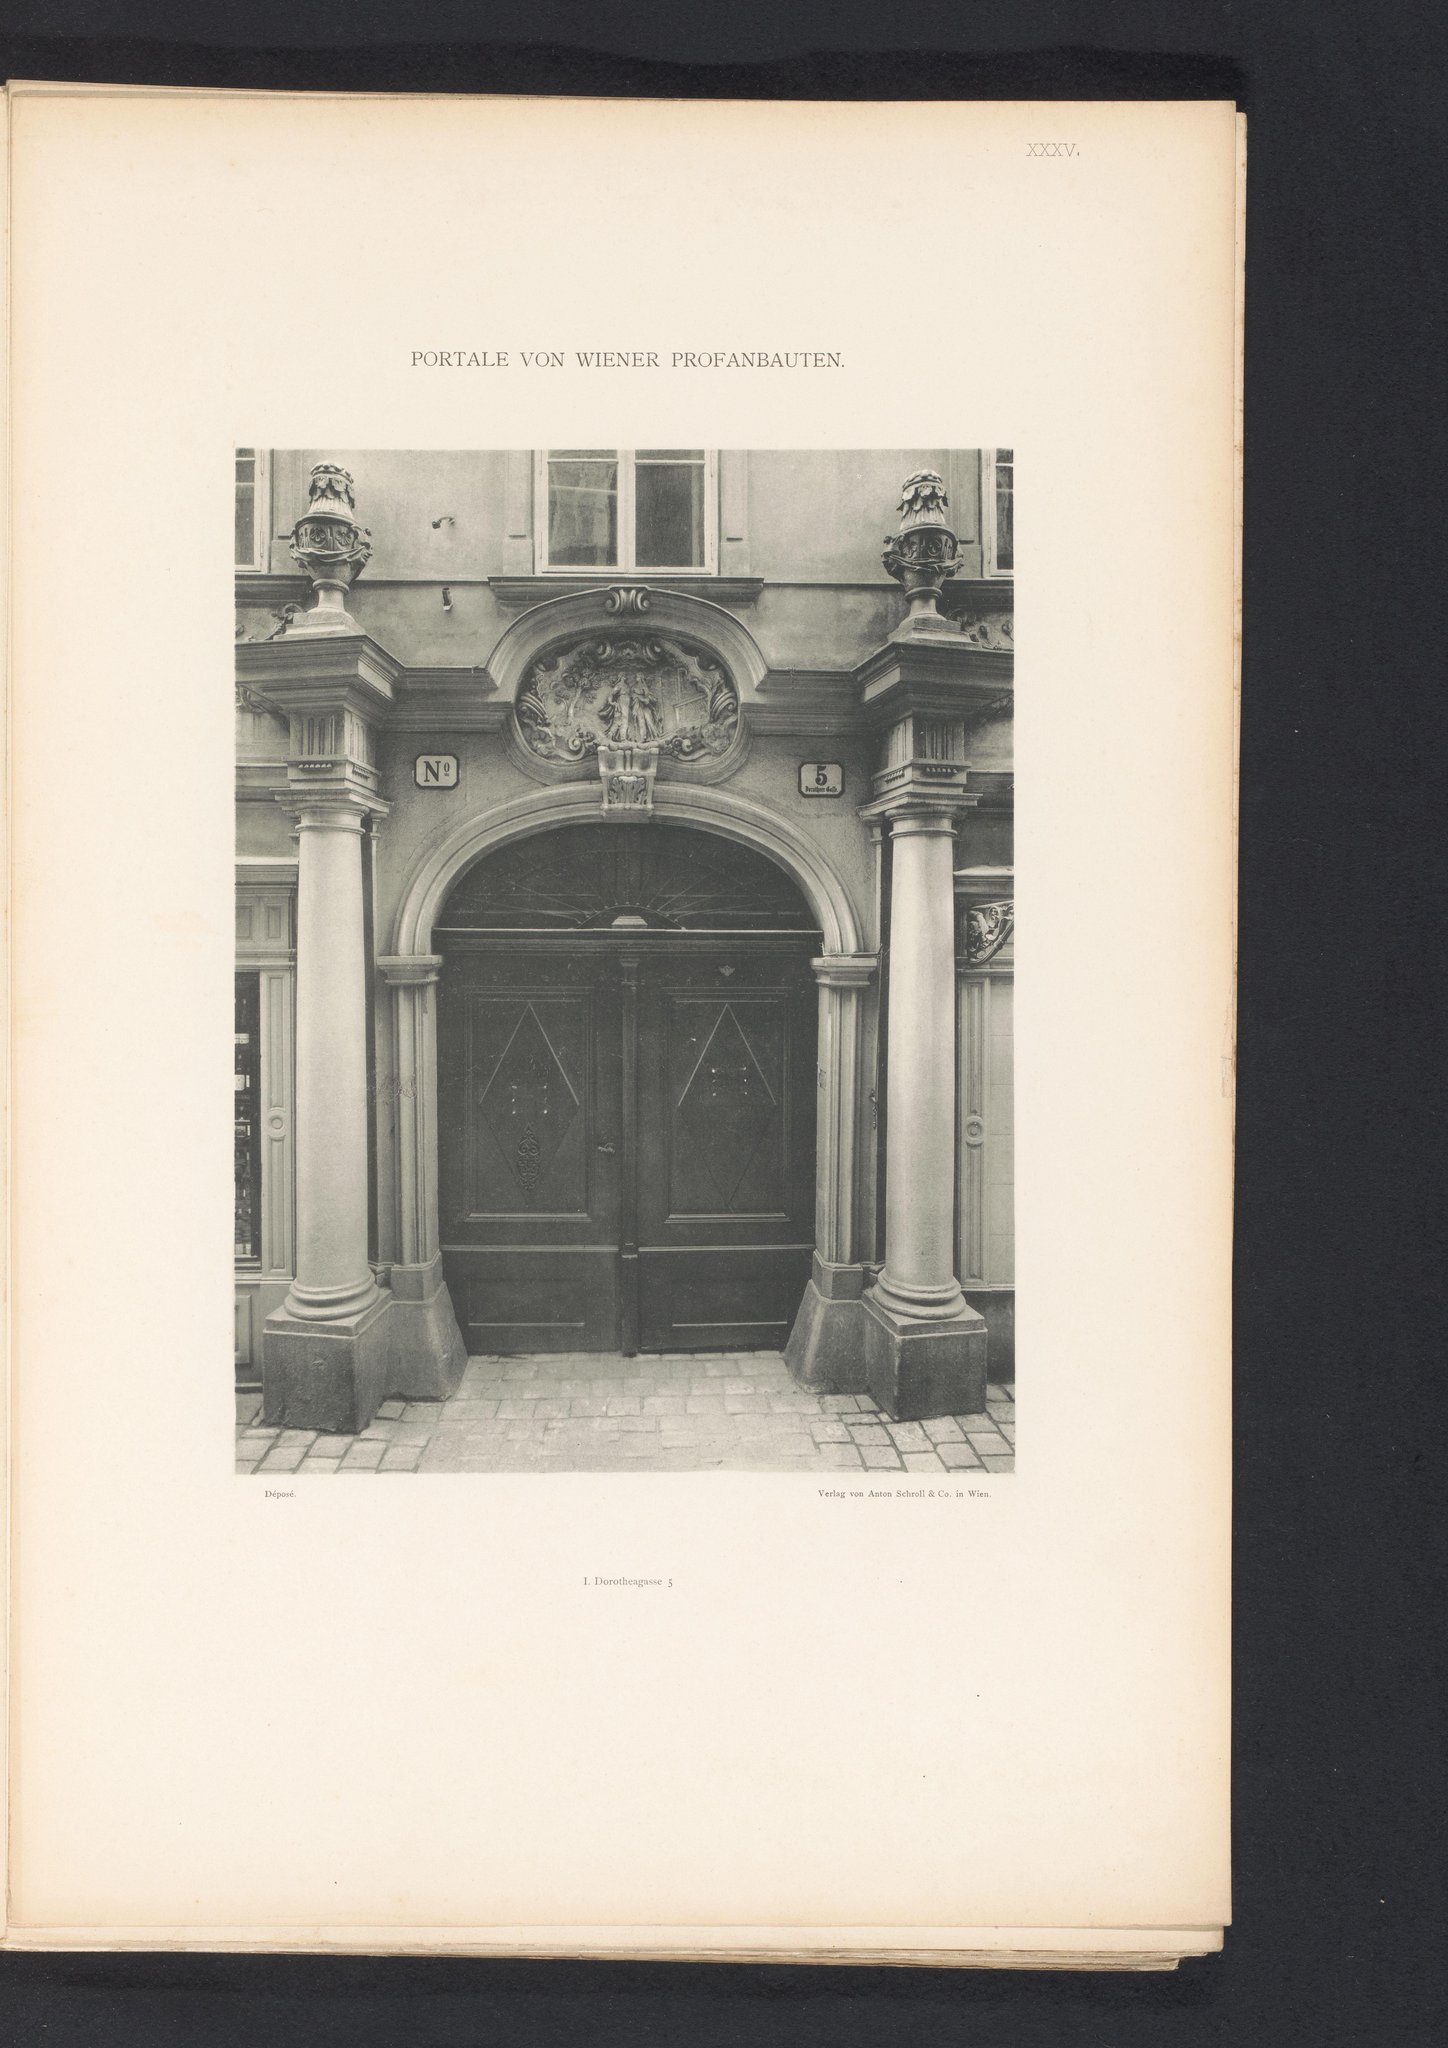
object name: page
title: Toegangsportaal van een pand aan Dorotheagasse 5 te Wenen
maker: Anonymous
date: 1884-1894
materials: paper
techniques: photograph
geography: austria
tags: gate, entrance, façade (of house or building)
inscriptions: inscription: ‘I. Dorotheagasse 5’, number: ‘XXXV.’